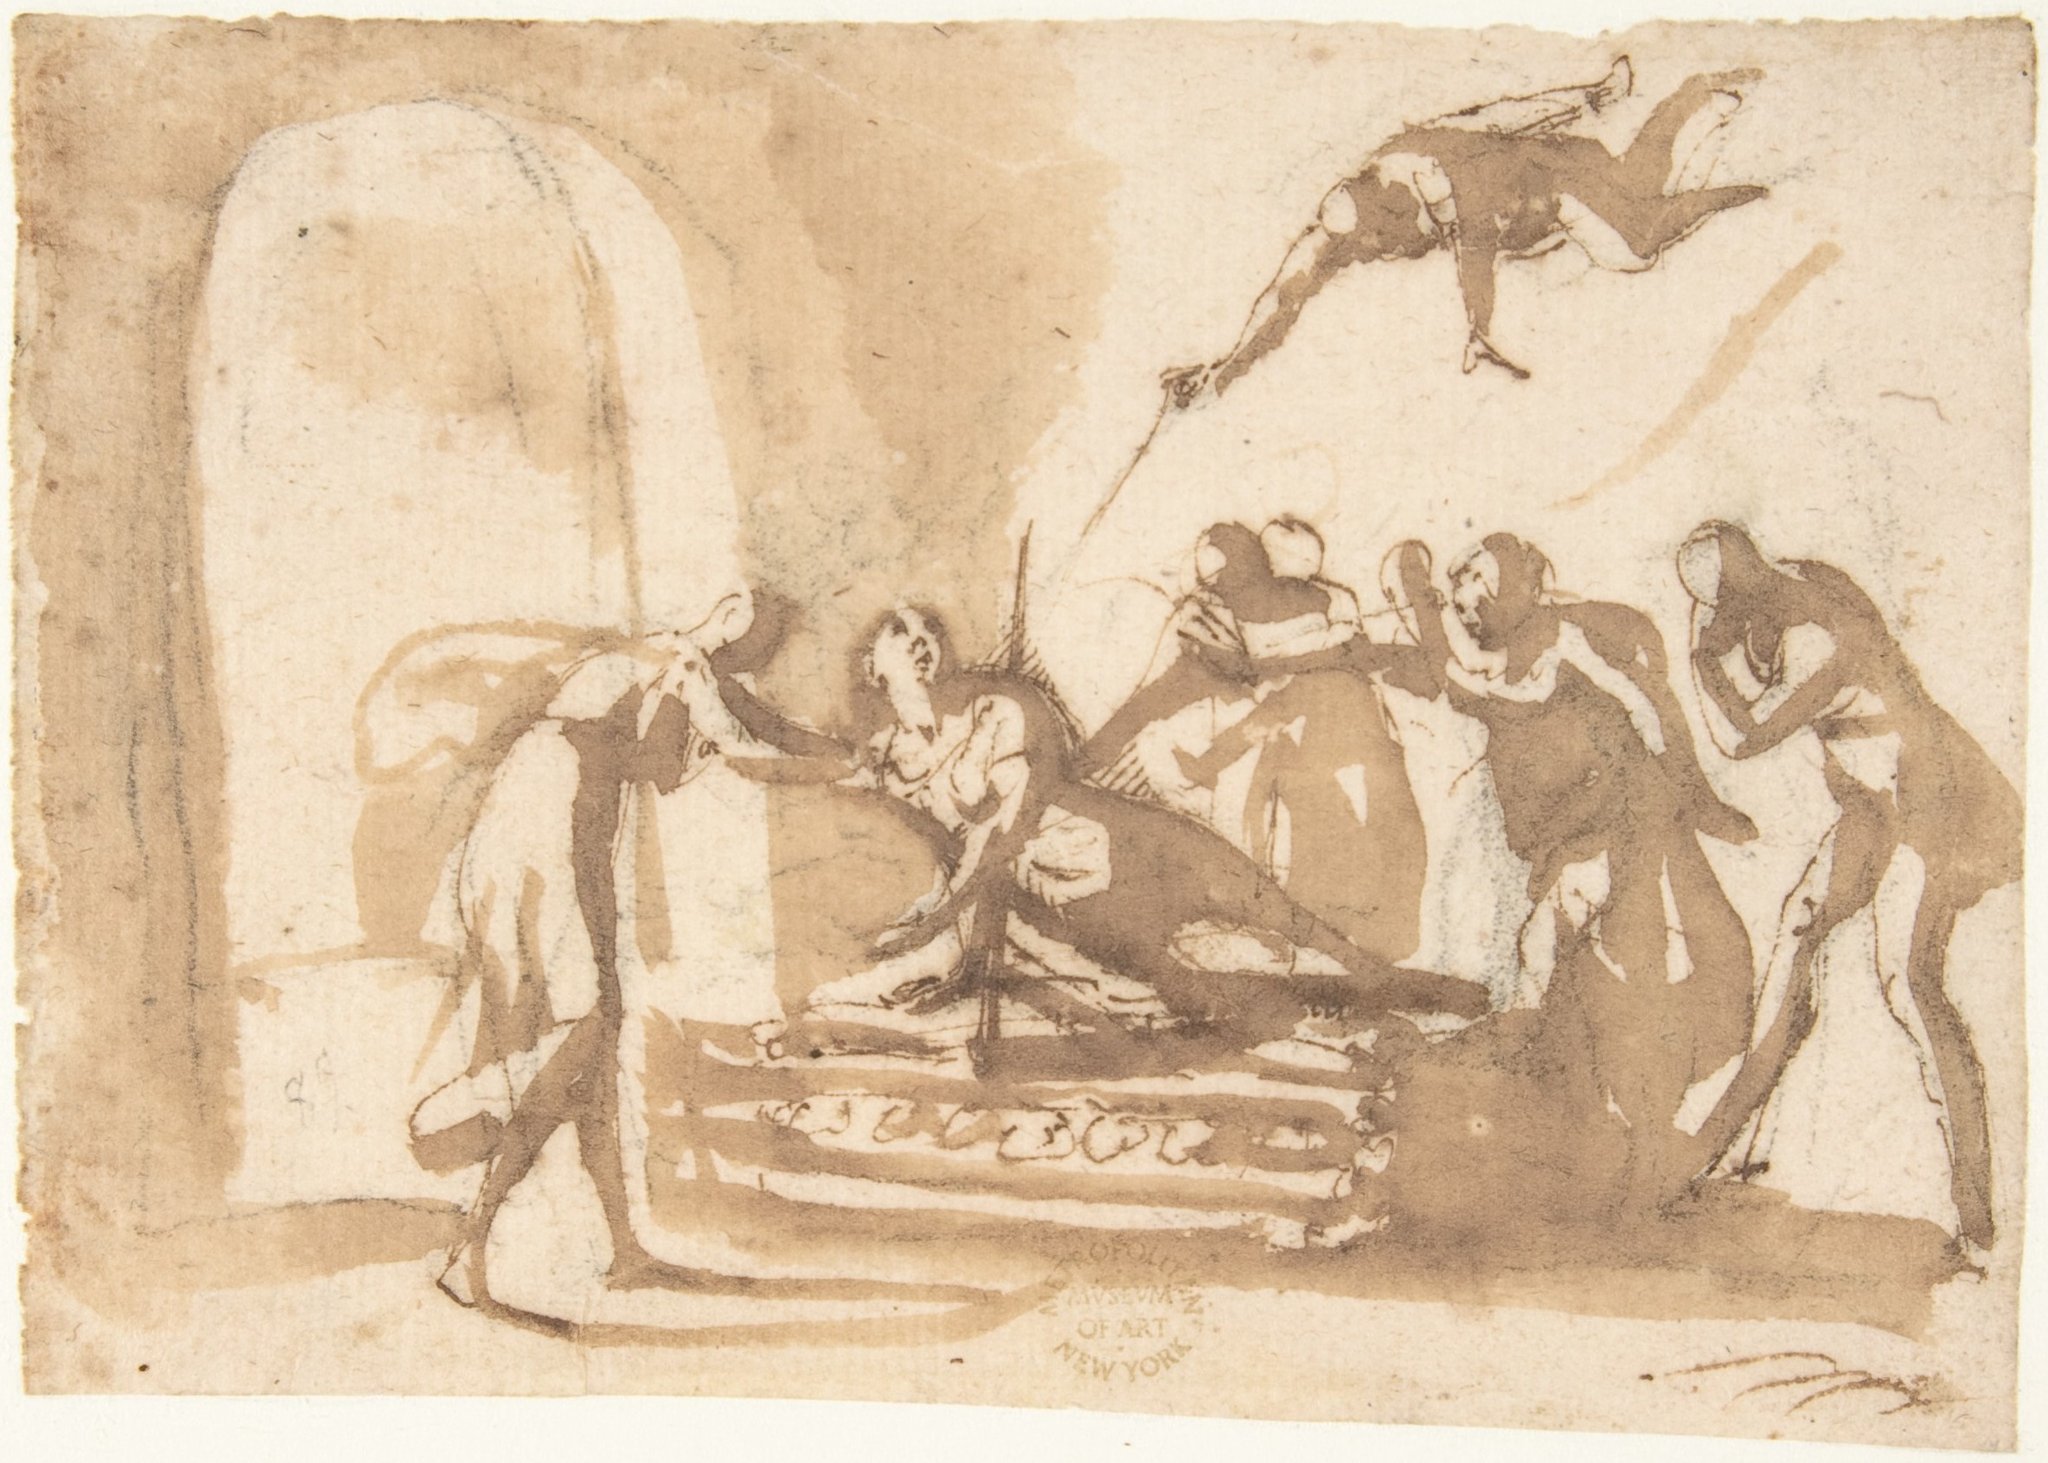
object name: drawing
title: The Death of Dido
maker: francesco allegrini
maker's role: artist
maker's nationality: italian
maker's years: 1615-1679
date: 1624-1663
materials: chalk, ink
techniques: brush, pen, wash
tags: human figures,death